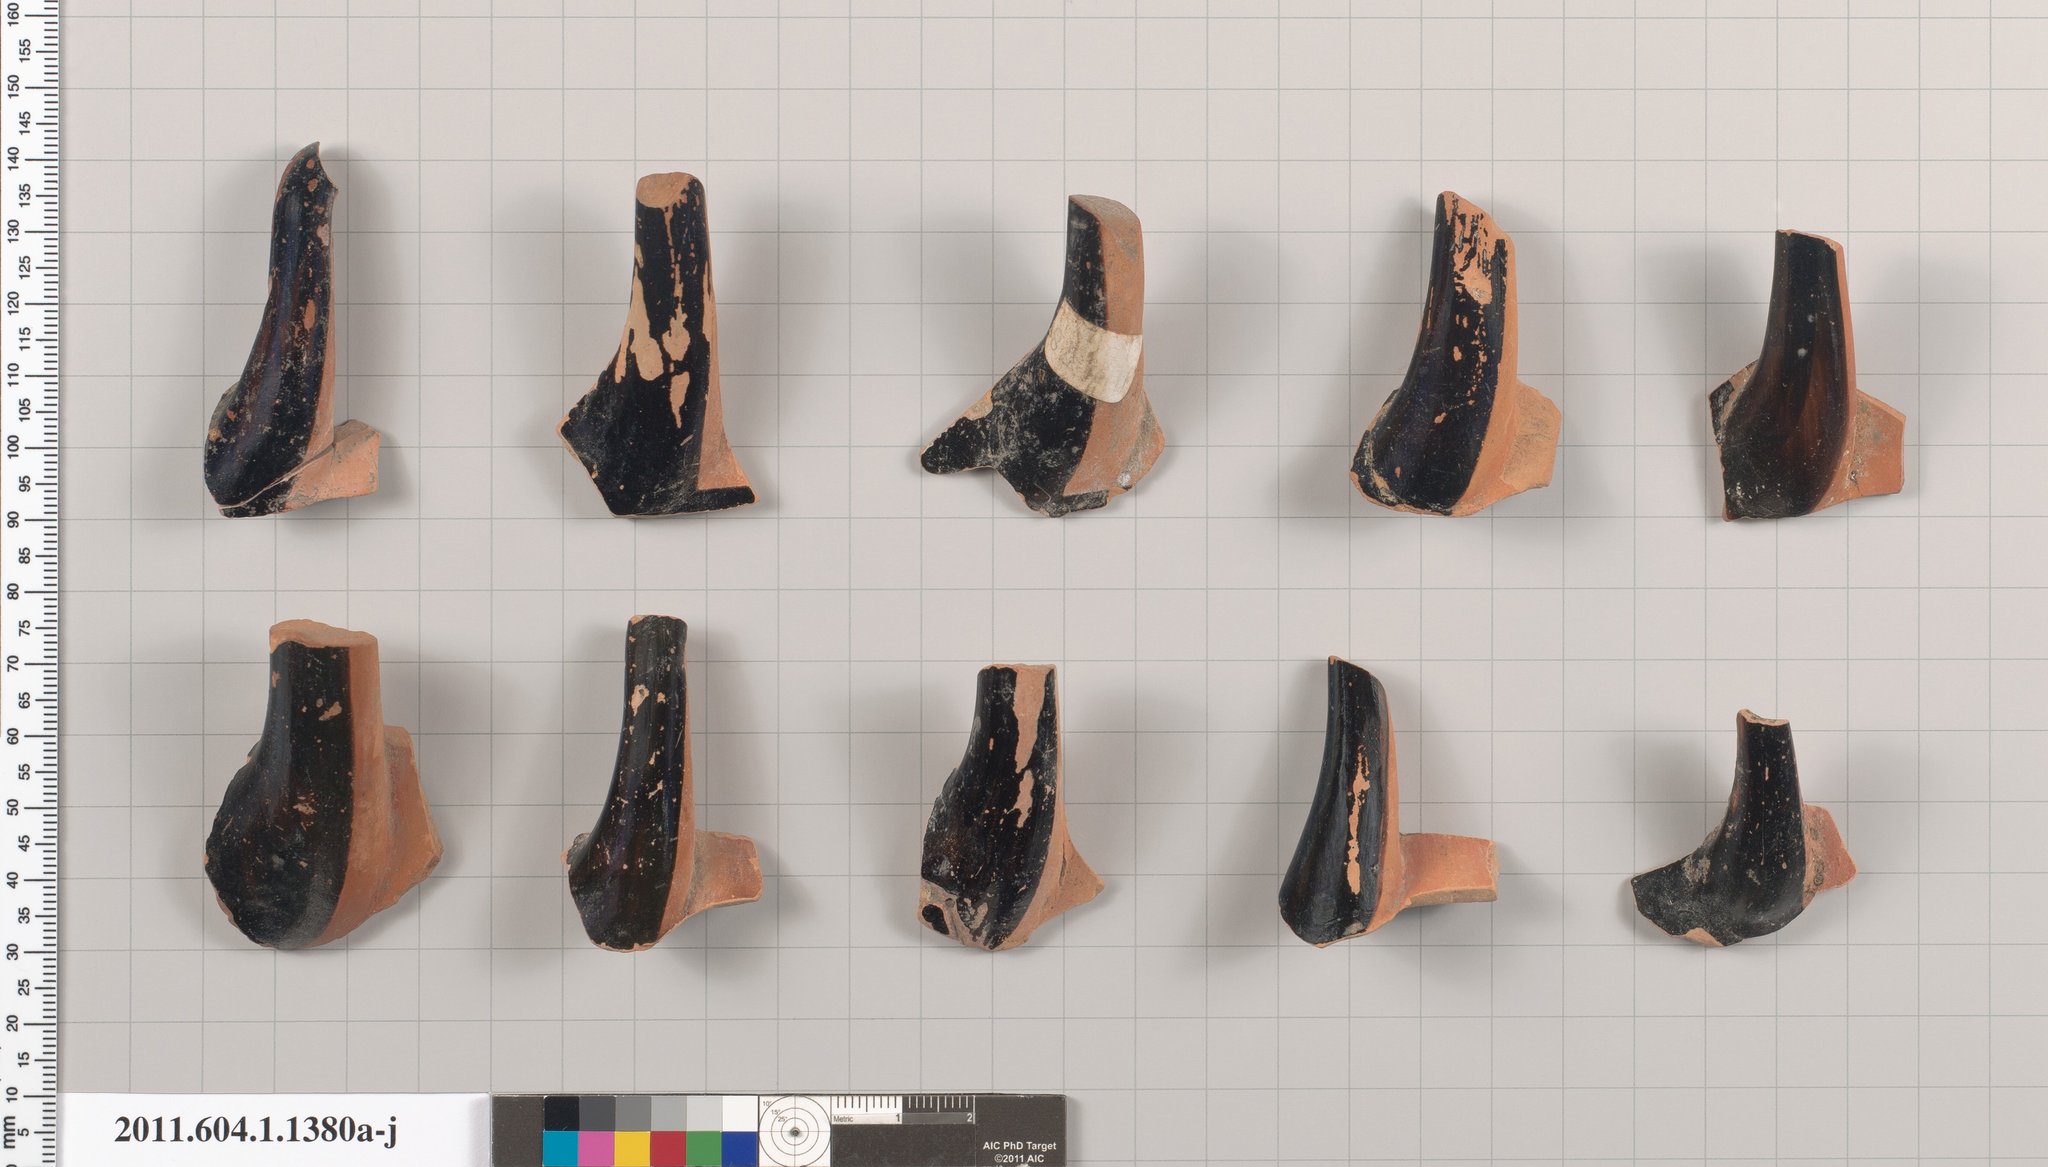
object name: kylix fragment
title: Terracotta fragments of kylikes (drinking cups)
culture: greek, attic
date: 500-401 BCE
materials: terracotta